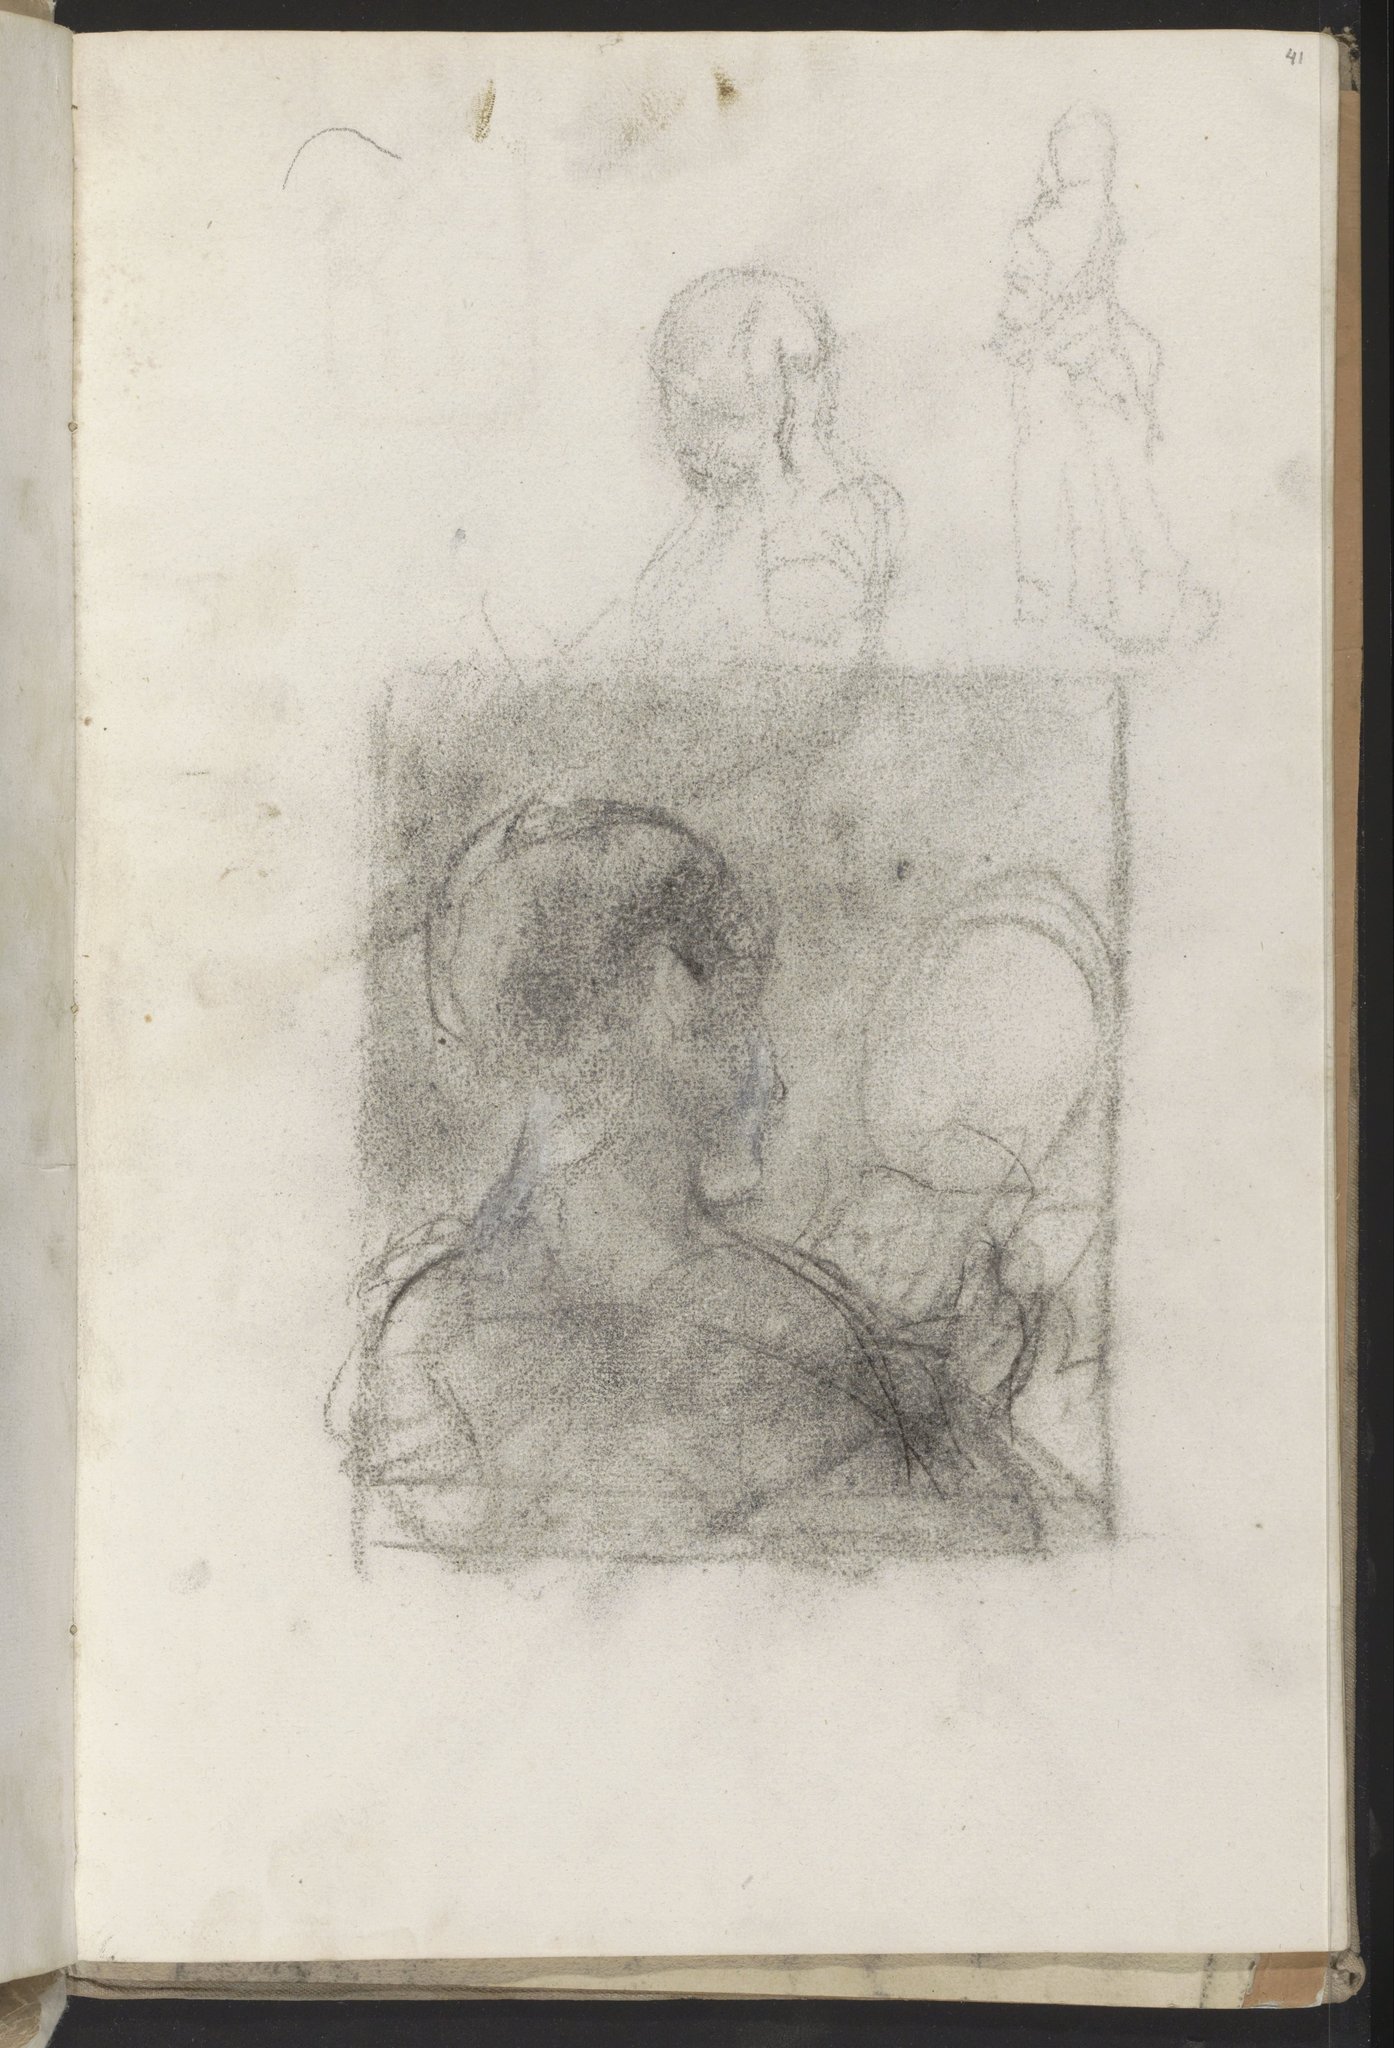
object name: sketchbook leaf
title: Lezende man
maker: albert neuhuys (1844-1914)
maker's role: draughtsman, painter, print maker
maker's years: 1844-1914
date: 1854-1914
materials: charcoal, paint, paper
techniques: brush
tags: adult woman, reading, adult man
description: Tevens twee figuurstudies. Blad 41 recto uit een schetsboek met 53 bladen.